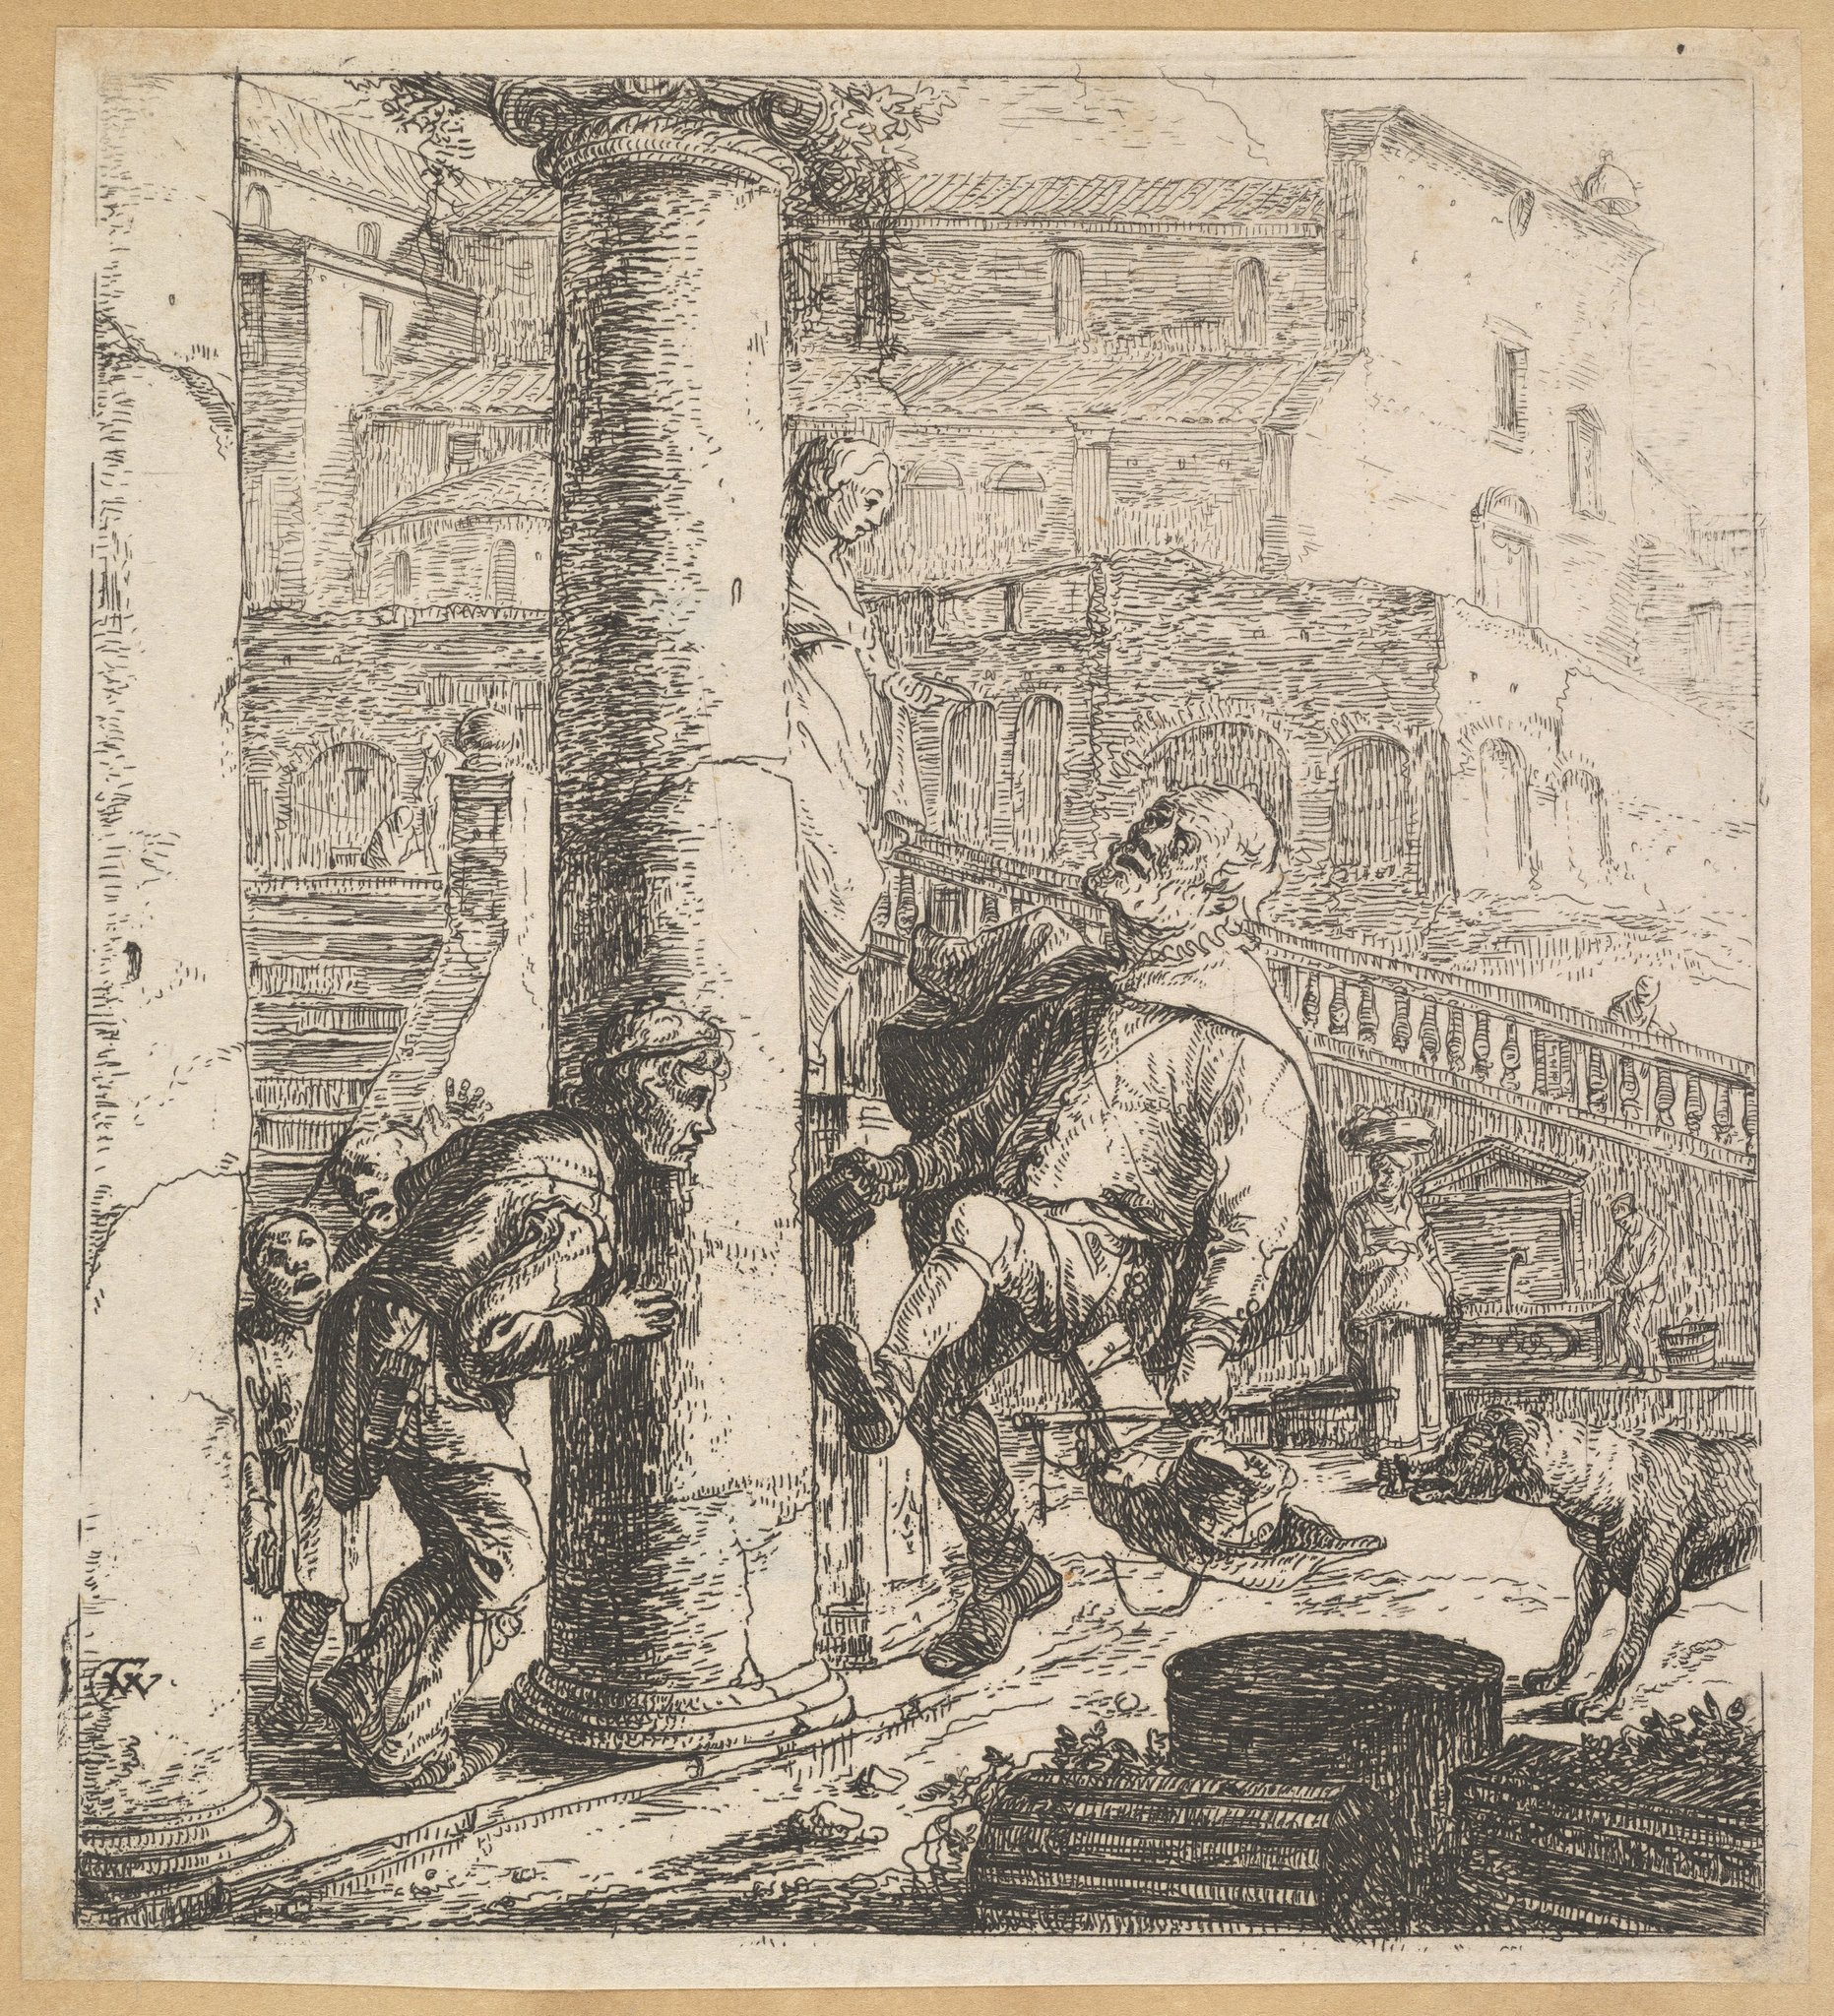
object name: print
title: Blind Beggar Bumping A Pillar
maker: thomas wijck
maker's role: artist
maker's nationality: dutch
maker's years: 1616-1677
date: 1601-1700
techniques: drypoint, etching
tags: columns,men,women,dogs